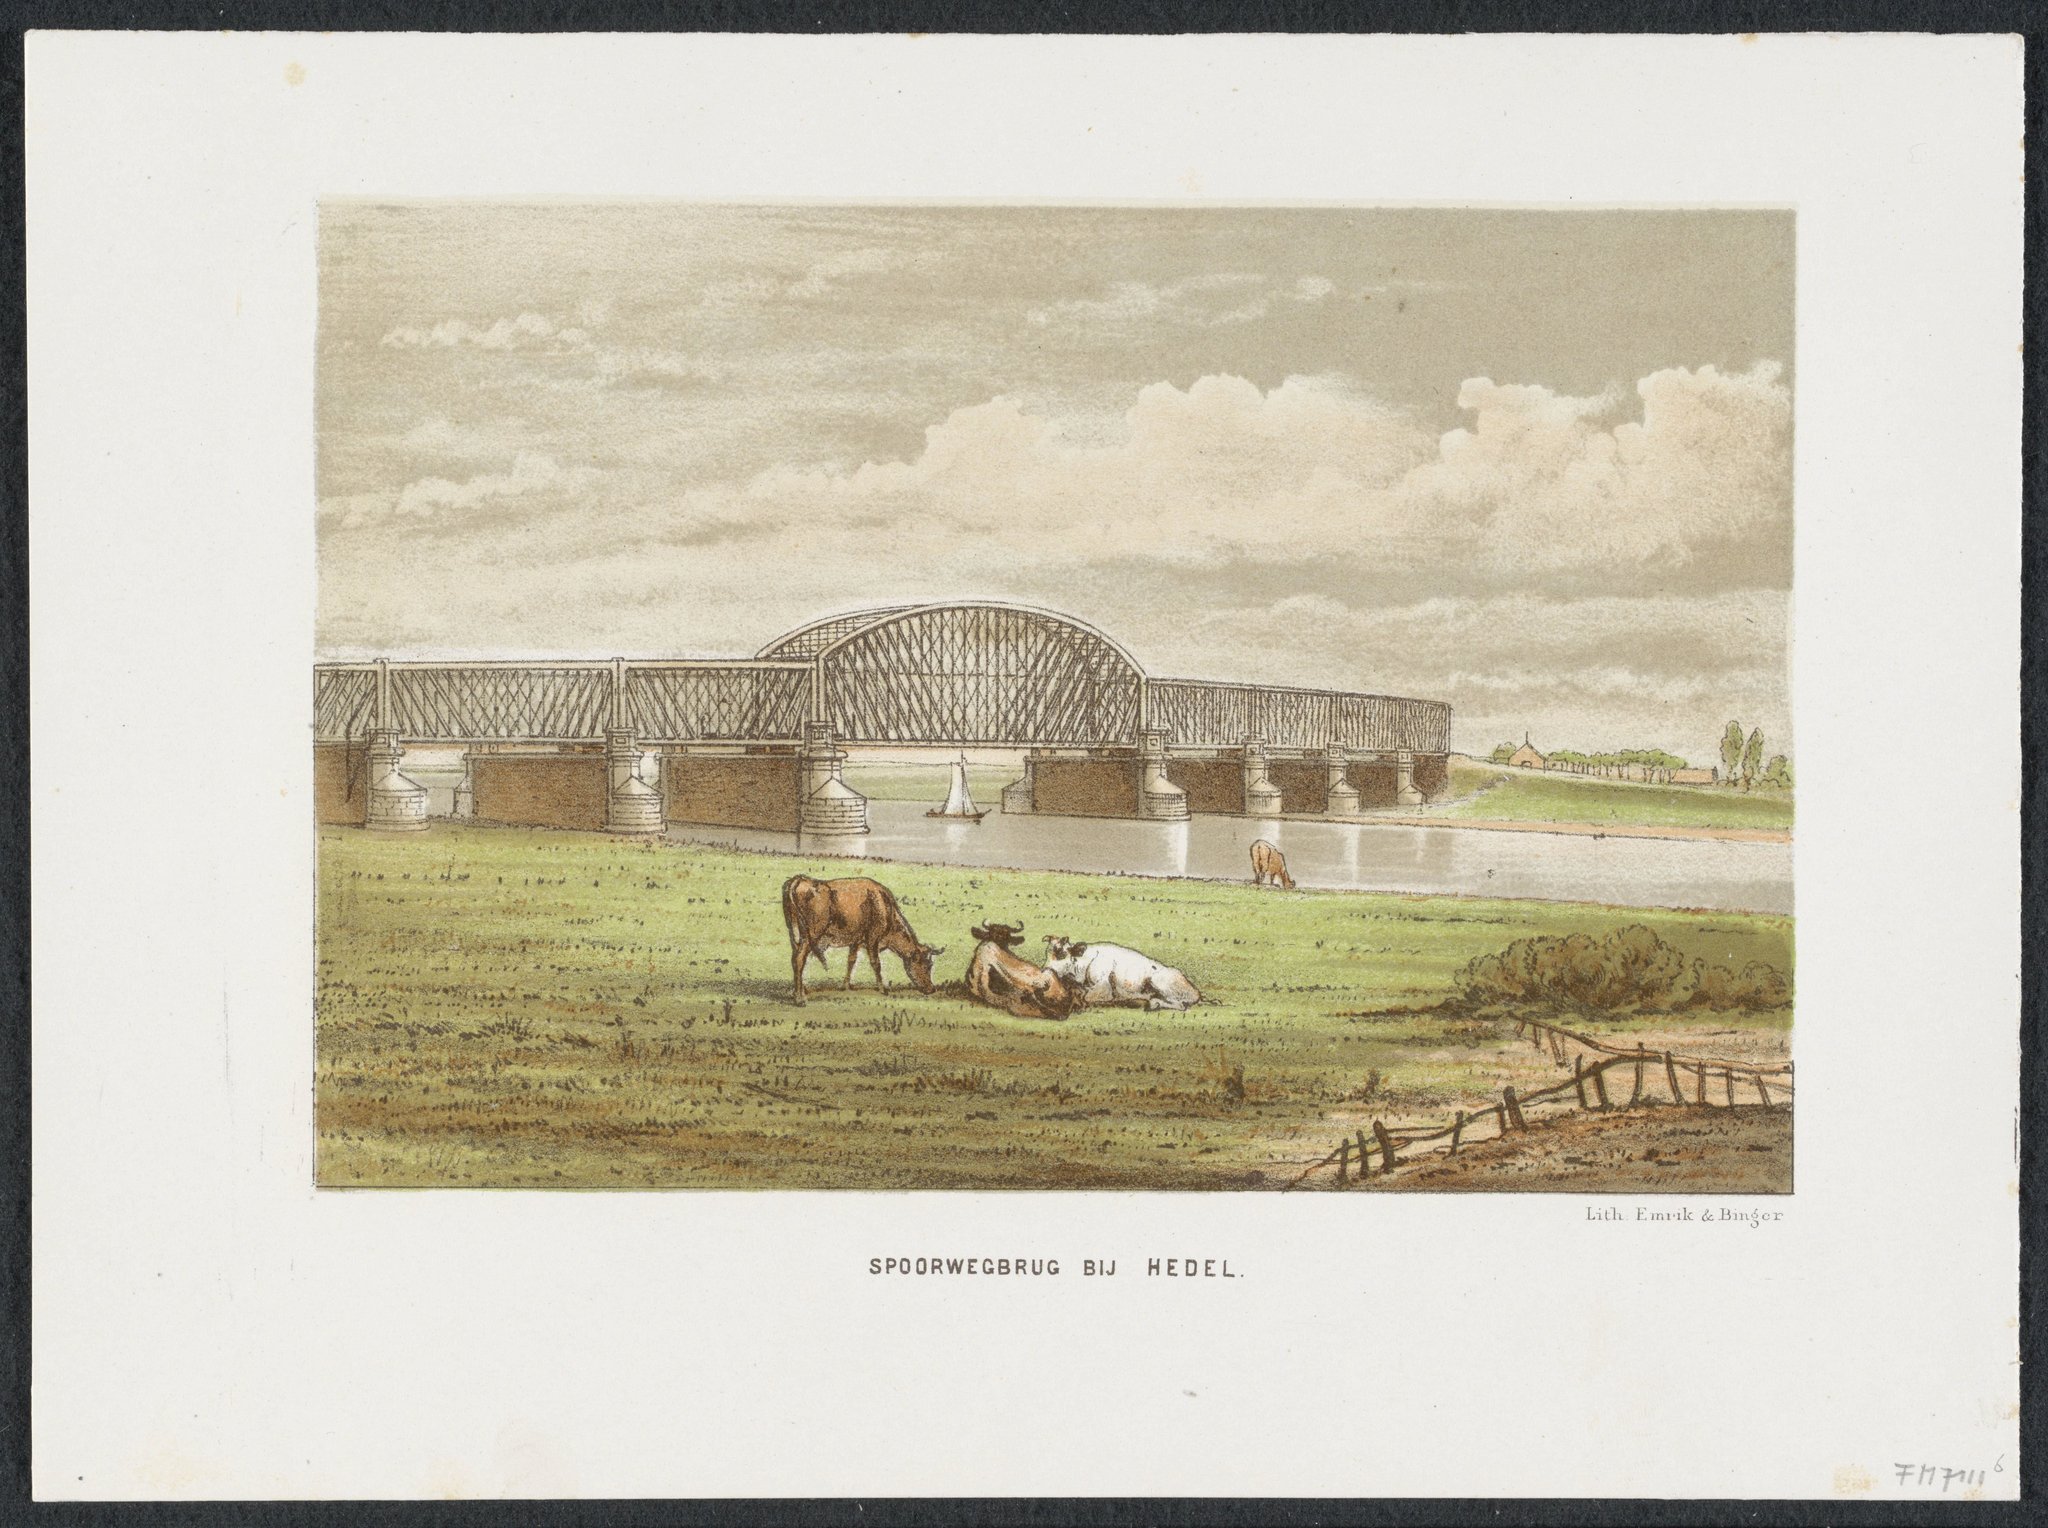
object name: print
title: De Voornaamste Spoorwegbruggen in Nederland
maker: Anonymous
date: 1872-1874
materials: paper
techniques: chromolithography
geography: haarlem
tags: railway, train, bridge, steam locomotive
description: De spoorbrug over de Maas bij 's-Hertogenbosch en Hedel, in gebruik genomen in 1870. Plaat in een boekje uit 1874 met acht platen van spoorbruggen gebouwd in Nederland uit de jaren 1846-1874.